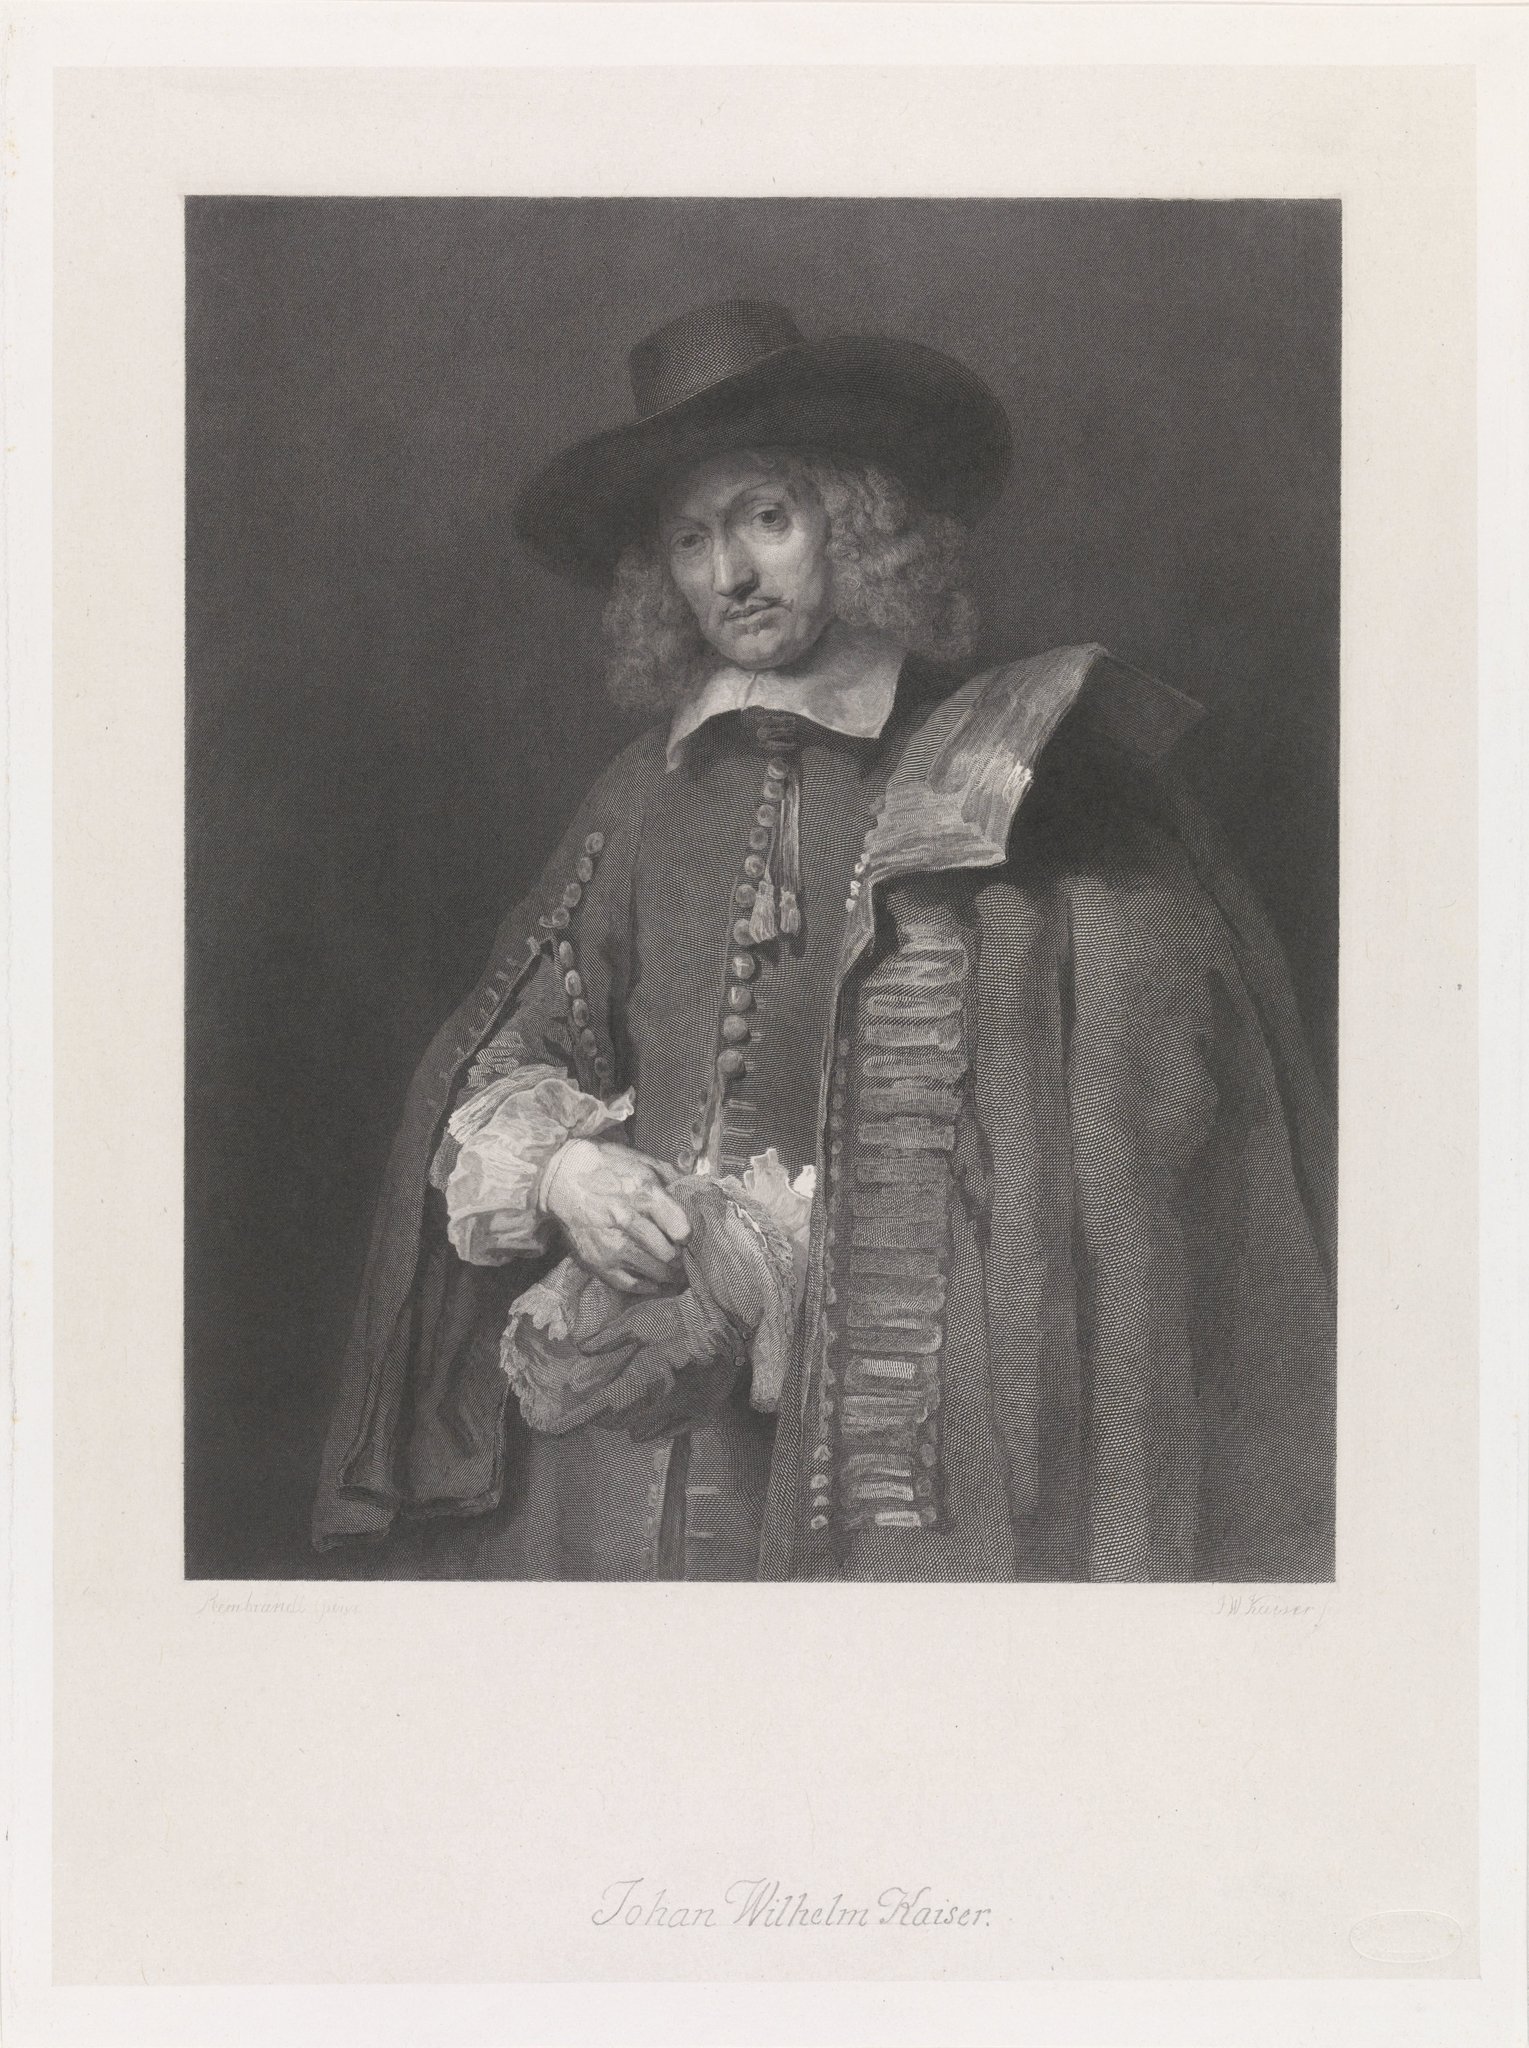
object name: print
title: Portret van Jan Six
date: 1823-1853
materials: paper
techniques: engraving, etching, roulette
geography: amsterdam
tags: amsterdam, mayor, jan six (1618-1700)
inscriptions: inscription: ‘Johan Wilhelm Kaiser.’, collector's mark: ‘François Buffa & Fils Amsterdam’, collector's mark: Lugt 2228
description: Portret ten halven lijve van Jan Six, burgemeester van Amsterdam.